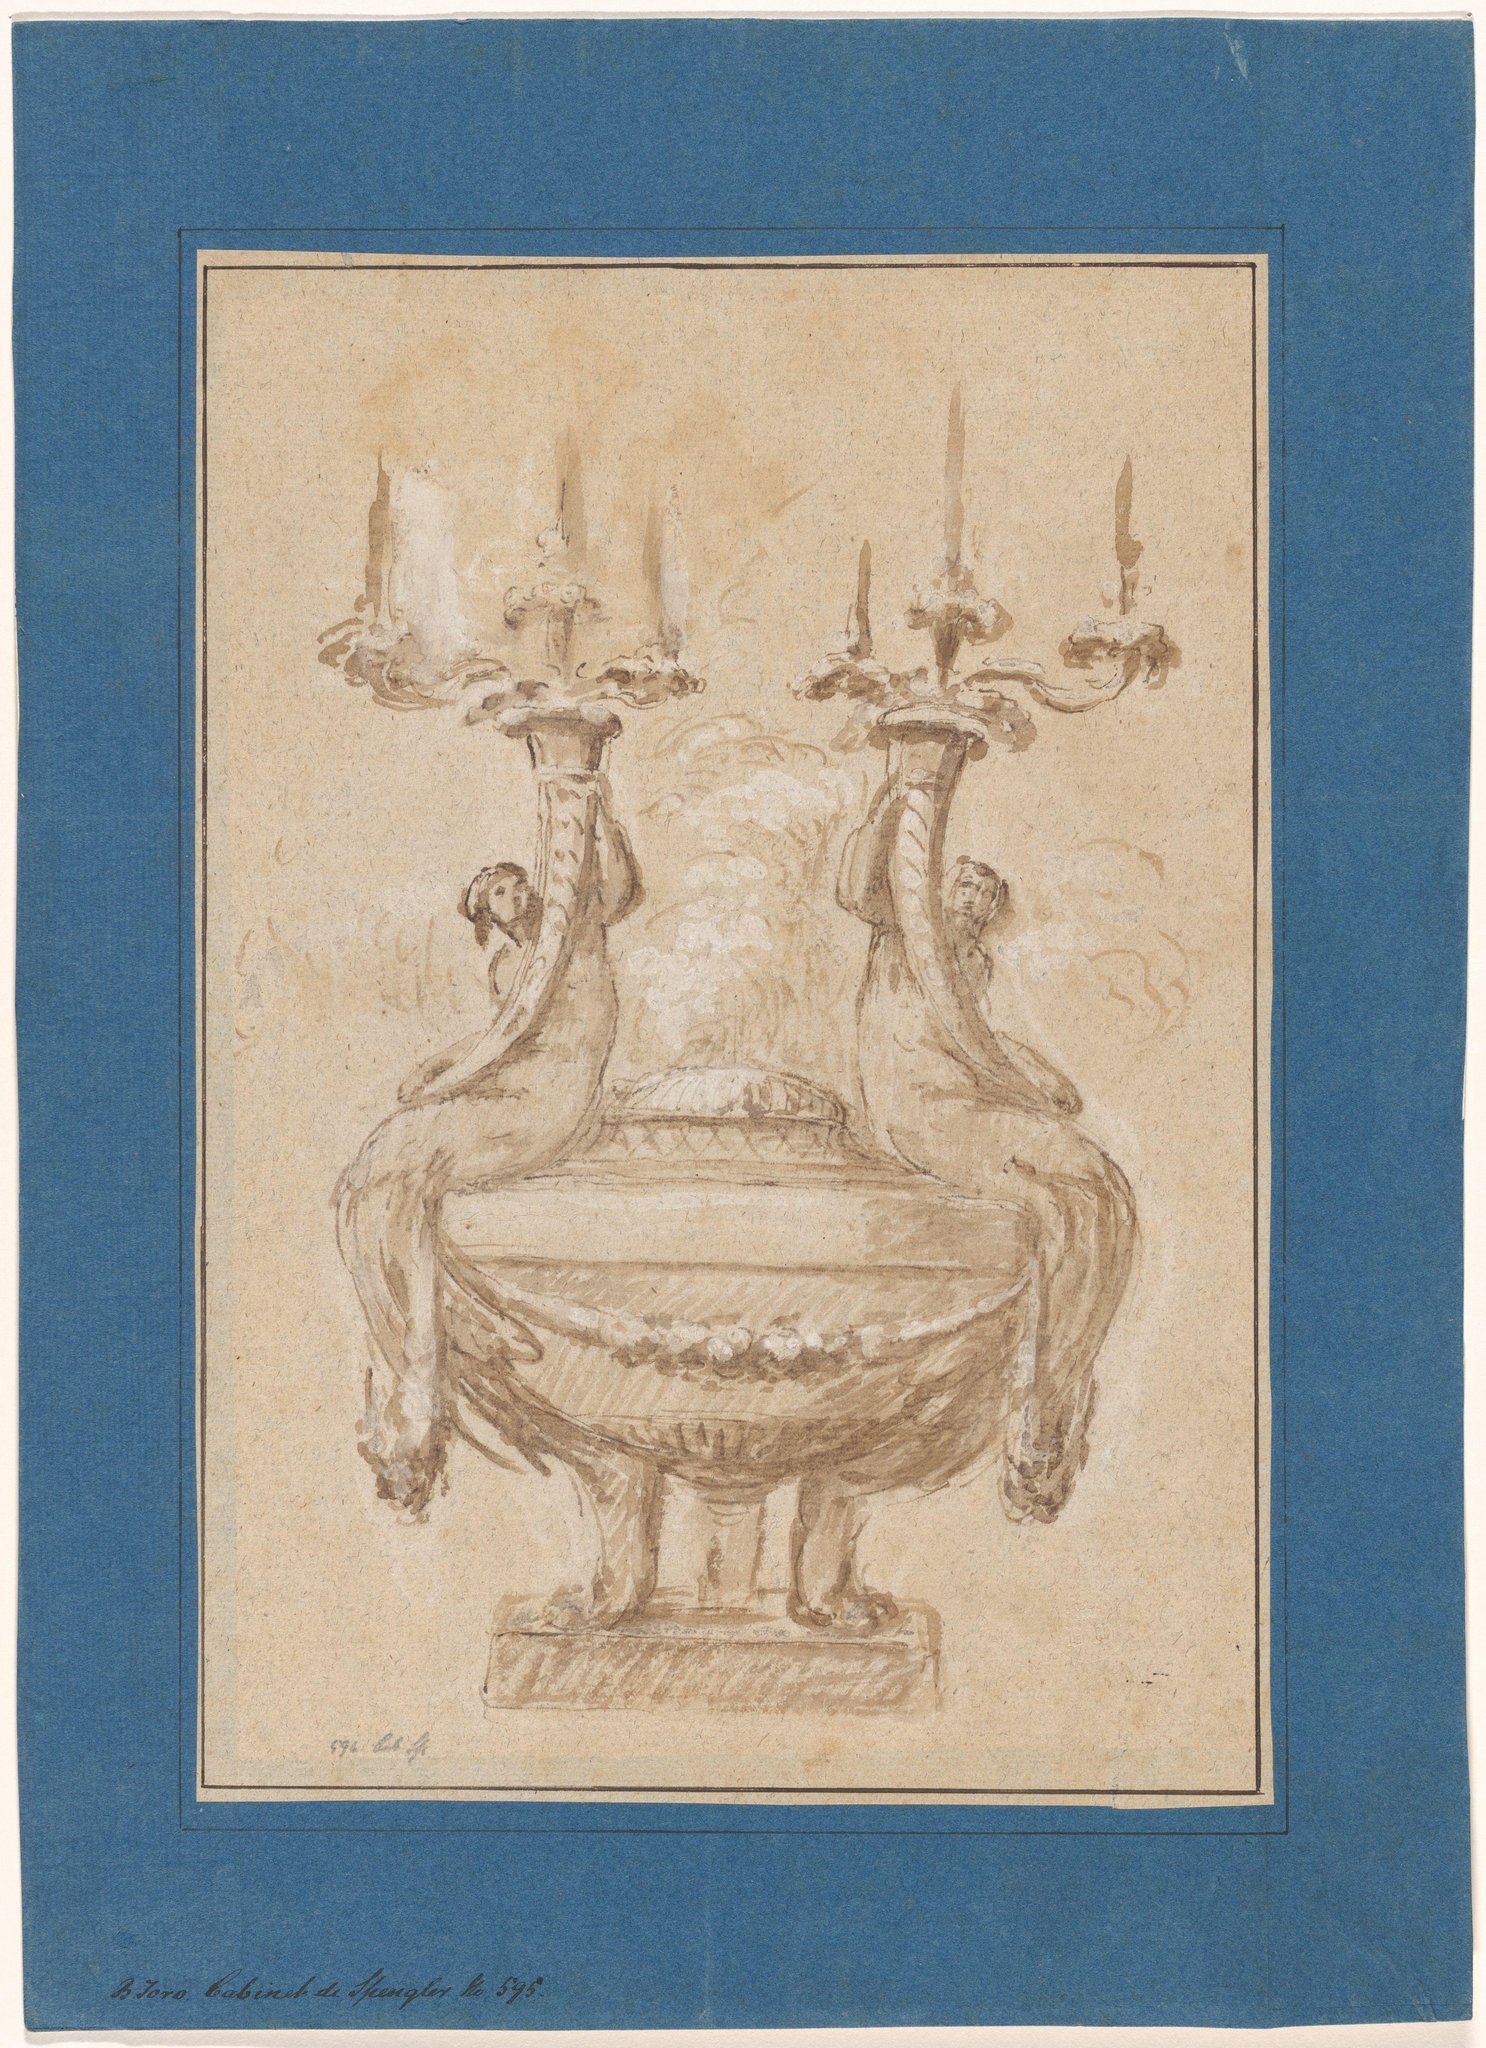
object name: design drawing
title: Ontwerp voor een kandelaber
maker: Anonymous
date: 1765-1775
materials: chalk, ink, paper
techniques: brush, pen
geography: paris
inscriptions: inscription: ‘596 Cab Sp’, collector's mark: Lugt 420, inscription: ‘B. Toro. Cab de Spengler No 595 [sic]’, number: ‘596’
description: Ontwerp voor een kandelaber in de vorm van een reukvaas met twee zittende Nereïden die elk een hoornvormige driearmige kandelaber dragen.